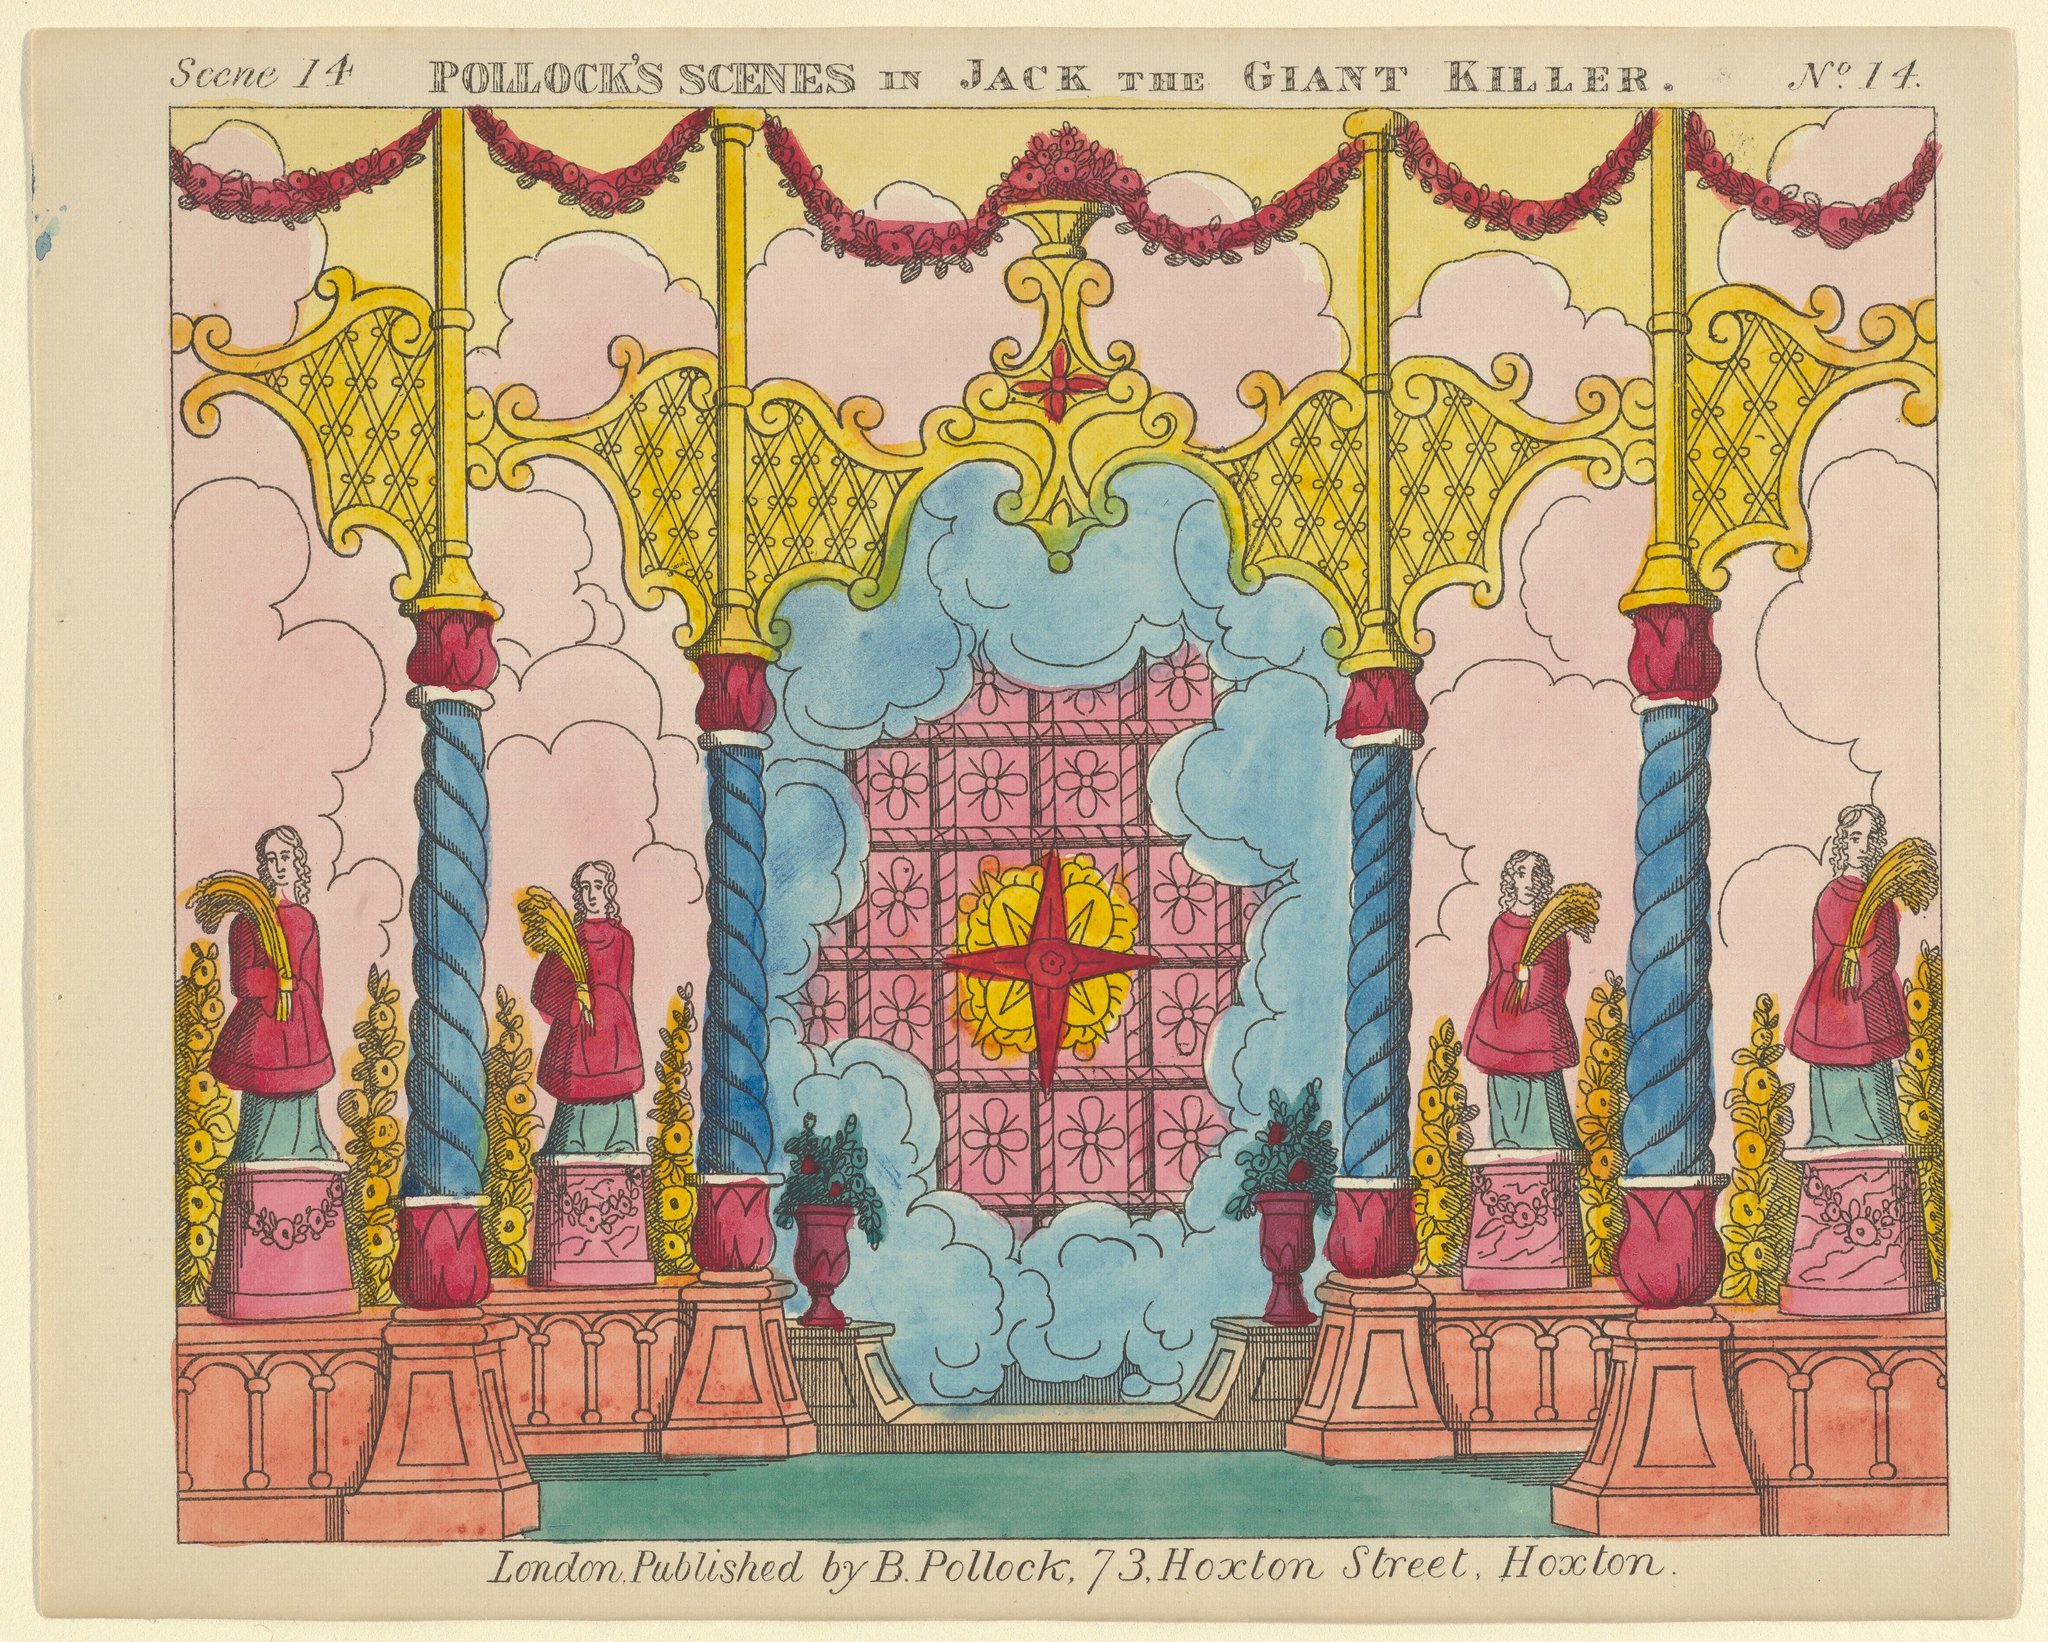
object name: print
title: Scene 14, from Jack and the Giant Killer, Scenes for a Toy Theater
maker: benjamin pollock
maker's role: publisher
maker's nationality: british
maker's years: 1857-1937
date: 1870-1890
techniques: lithograph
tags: theatre